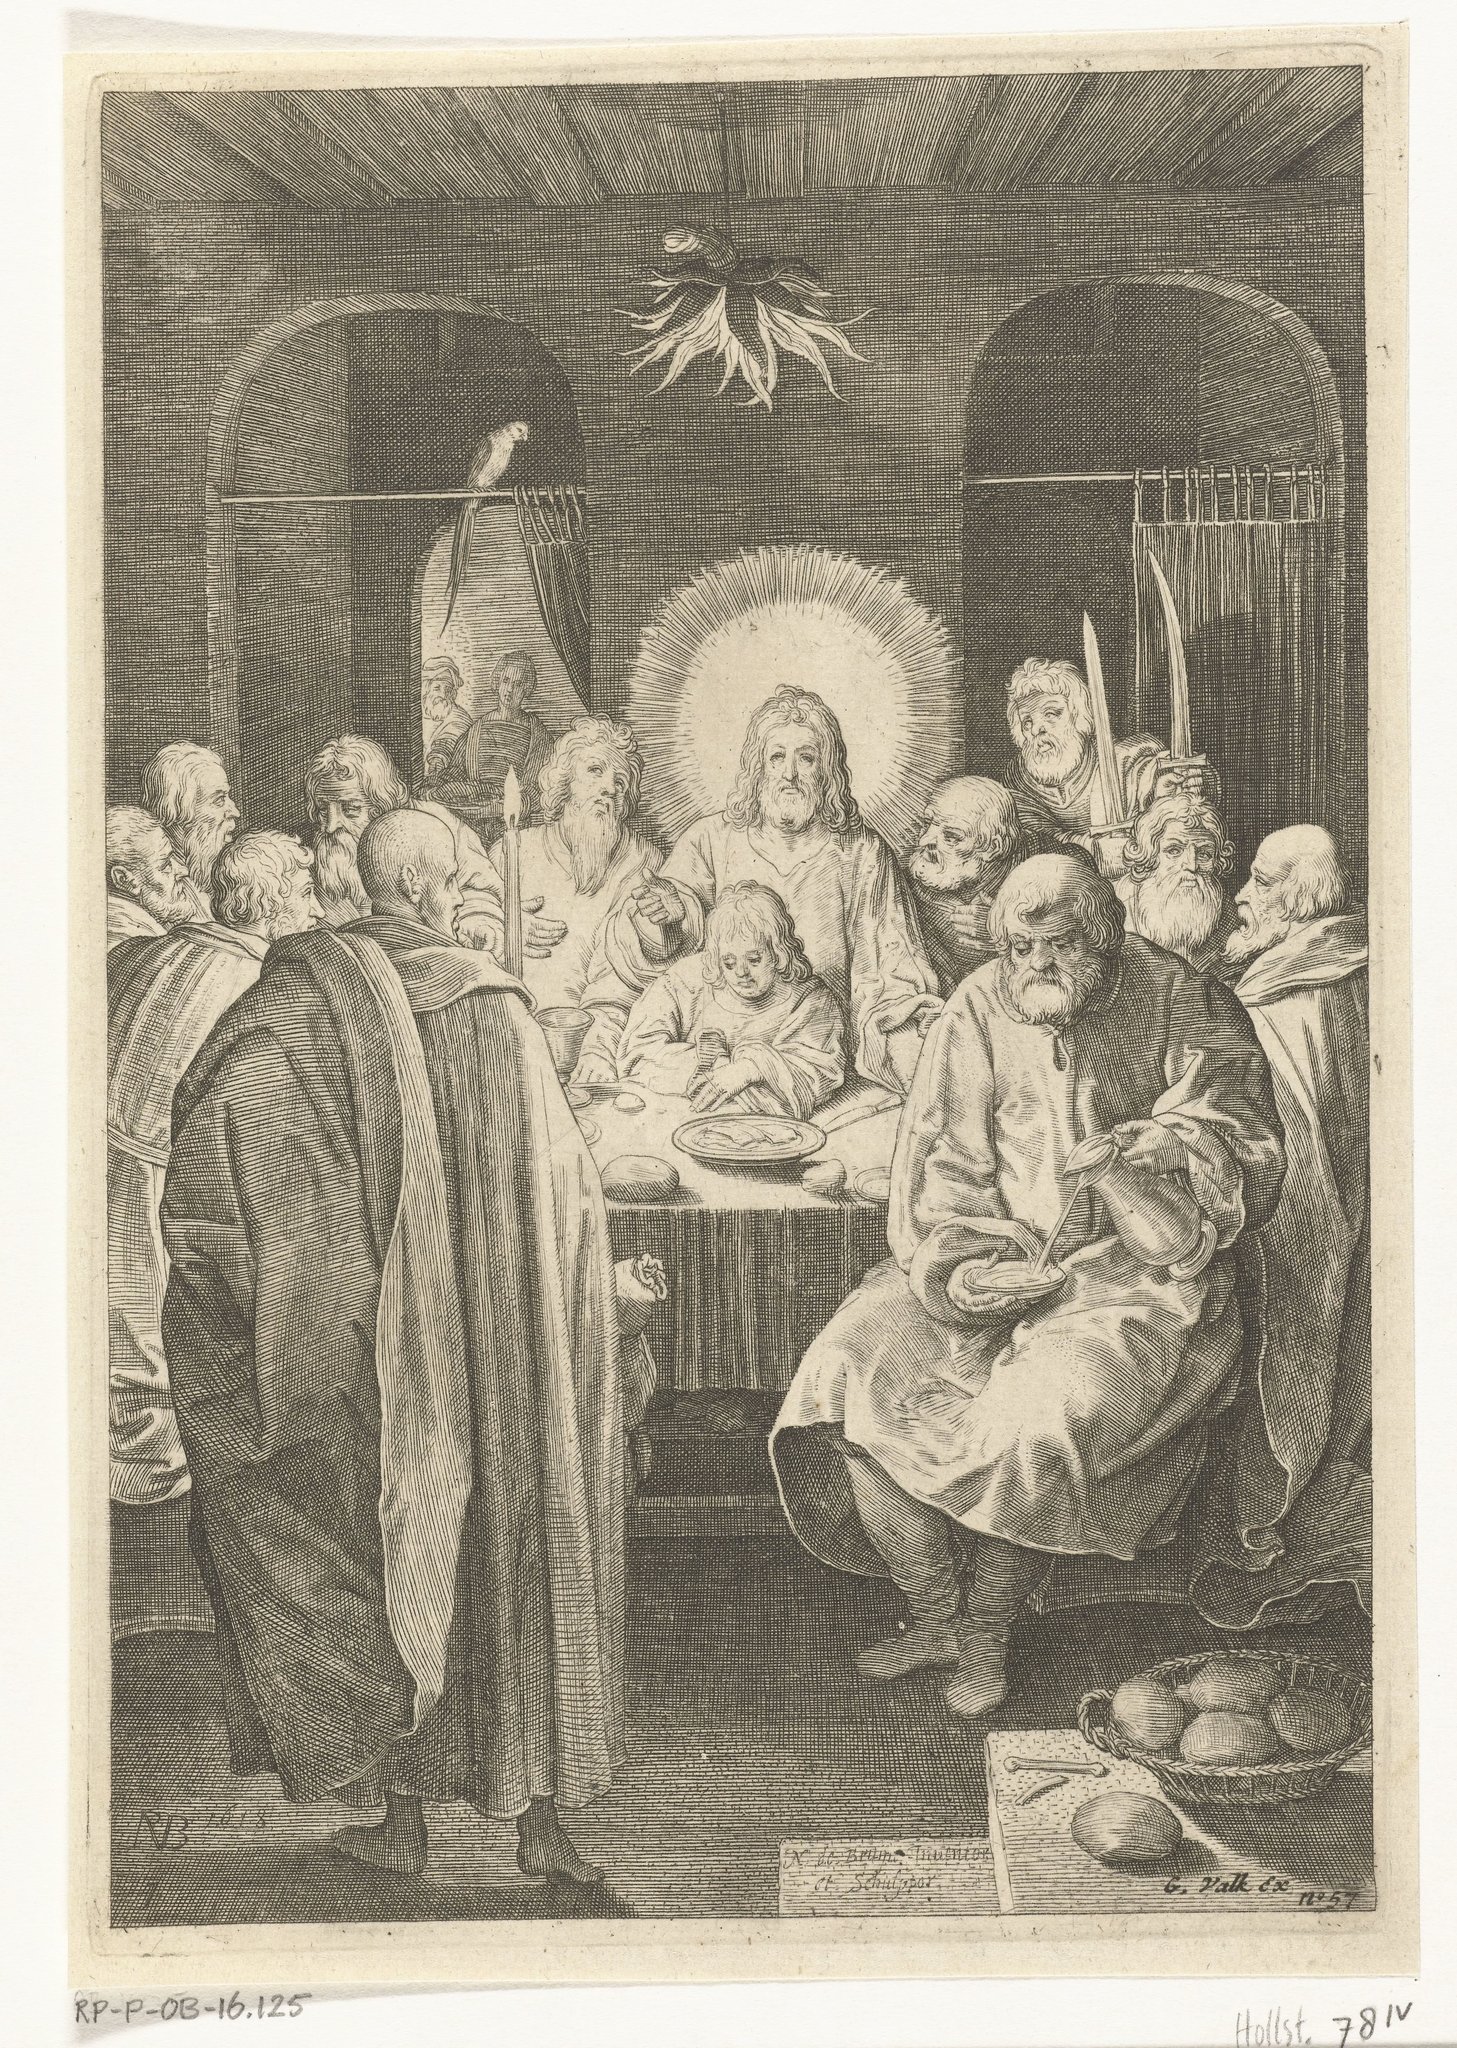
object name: print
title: De Passie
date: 1618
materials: paper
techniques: engraving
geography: netherlands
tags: last supper (in general) (matthew 26:21-35; mark 14:18-31; luke 22:3, 22:15-23; john 13:21-38)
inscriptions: date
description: Prent uit serie van twaalf prenten met scènes uit de Passie. Reeks geïnspireerd door de prenten van Hendrick Goltzius en Lucas van Leyden. Bij het adres van Gerard Valck staat het nummer 57.